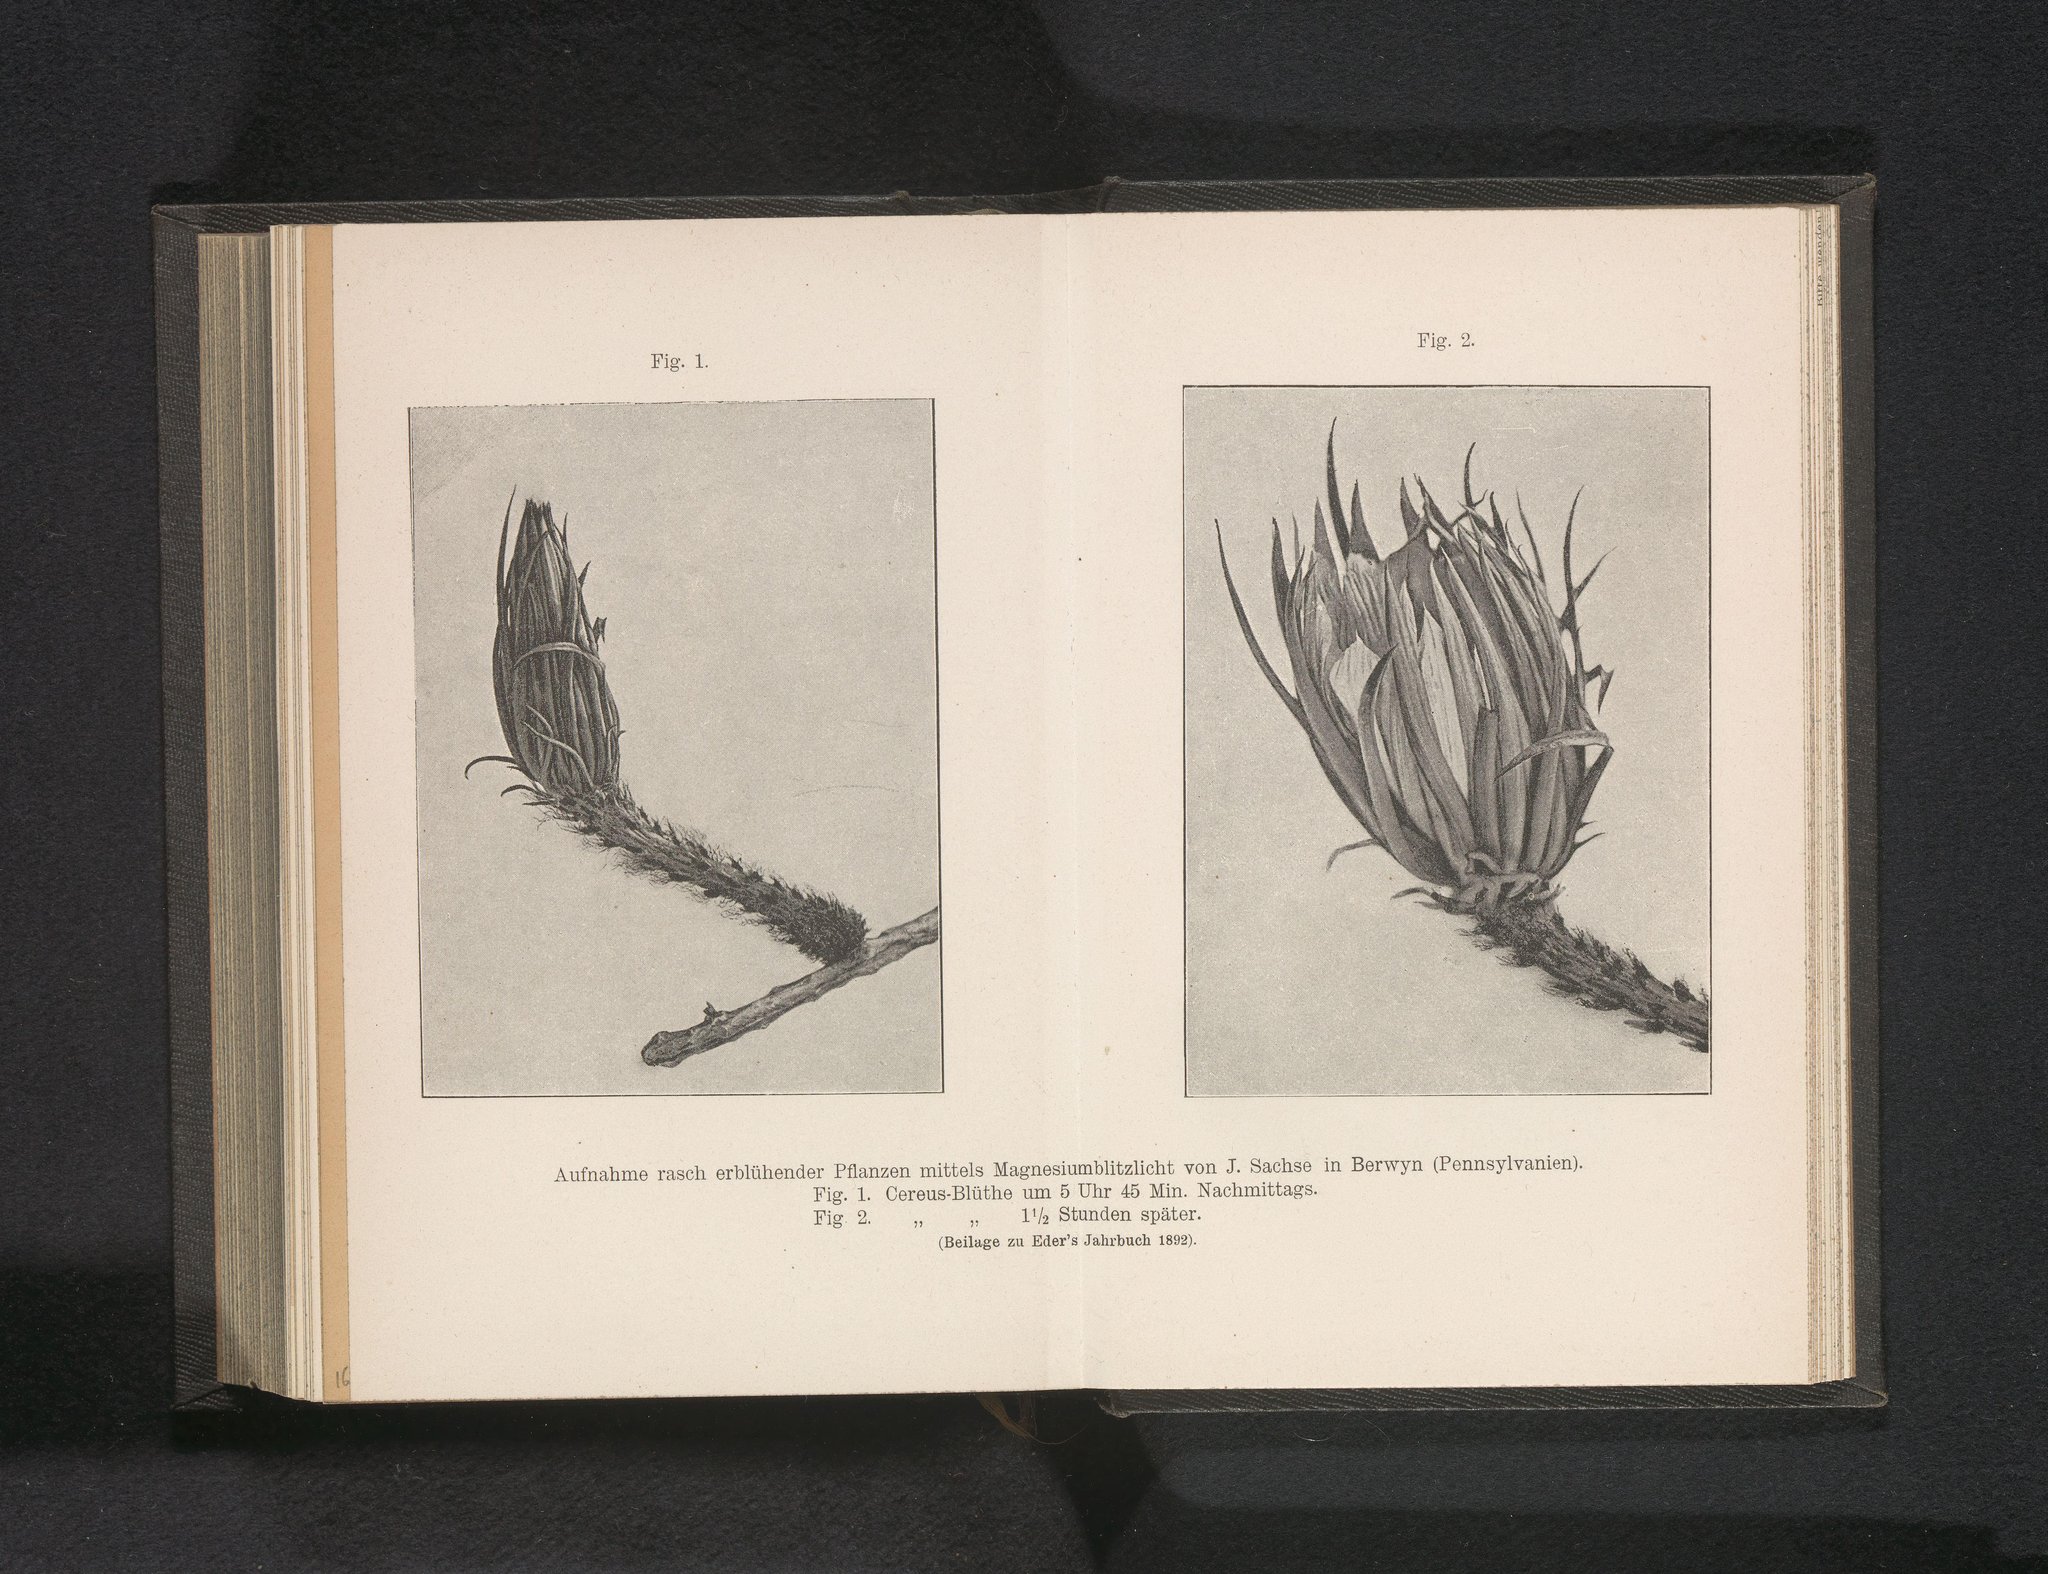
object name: page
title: Bloem van een cereus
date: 1887-1892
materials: paper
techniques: autotype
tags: plants and herbs: cactus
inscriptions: inscription: ‘Aufnahme rasch erblühender Planzen mittel Magnesiumblitzlicht von J. Sachse in Berwyn (Pennsylvanien)./ Fig. 1. Cereu-Blüthe um 5 Uhr 45 Min. Nachmittags/ Fig. 2. Cereus-Blüthe 1 1/2 Sunden später.’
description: Prent op vierendertigste ongenummerde pagina na pagina 520.